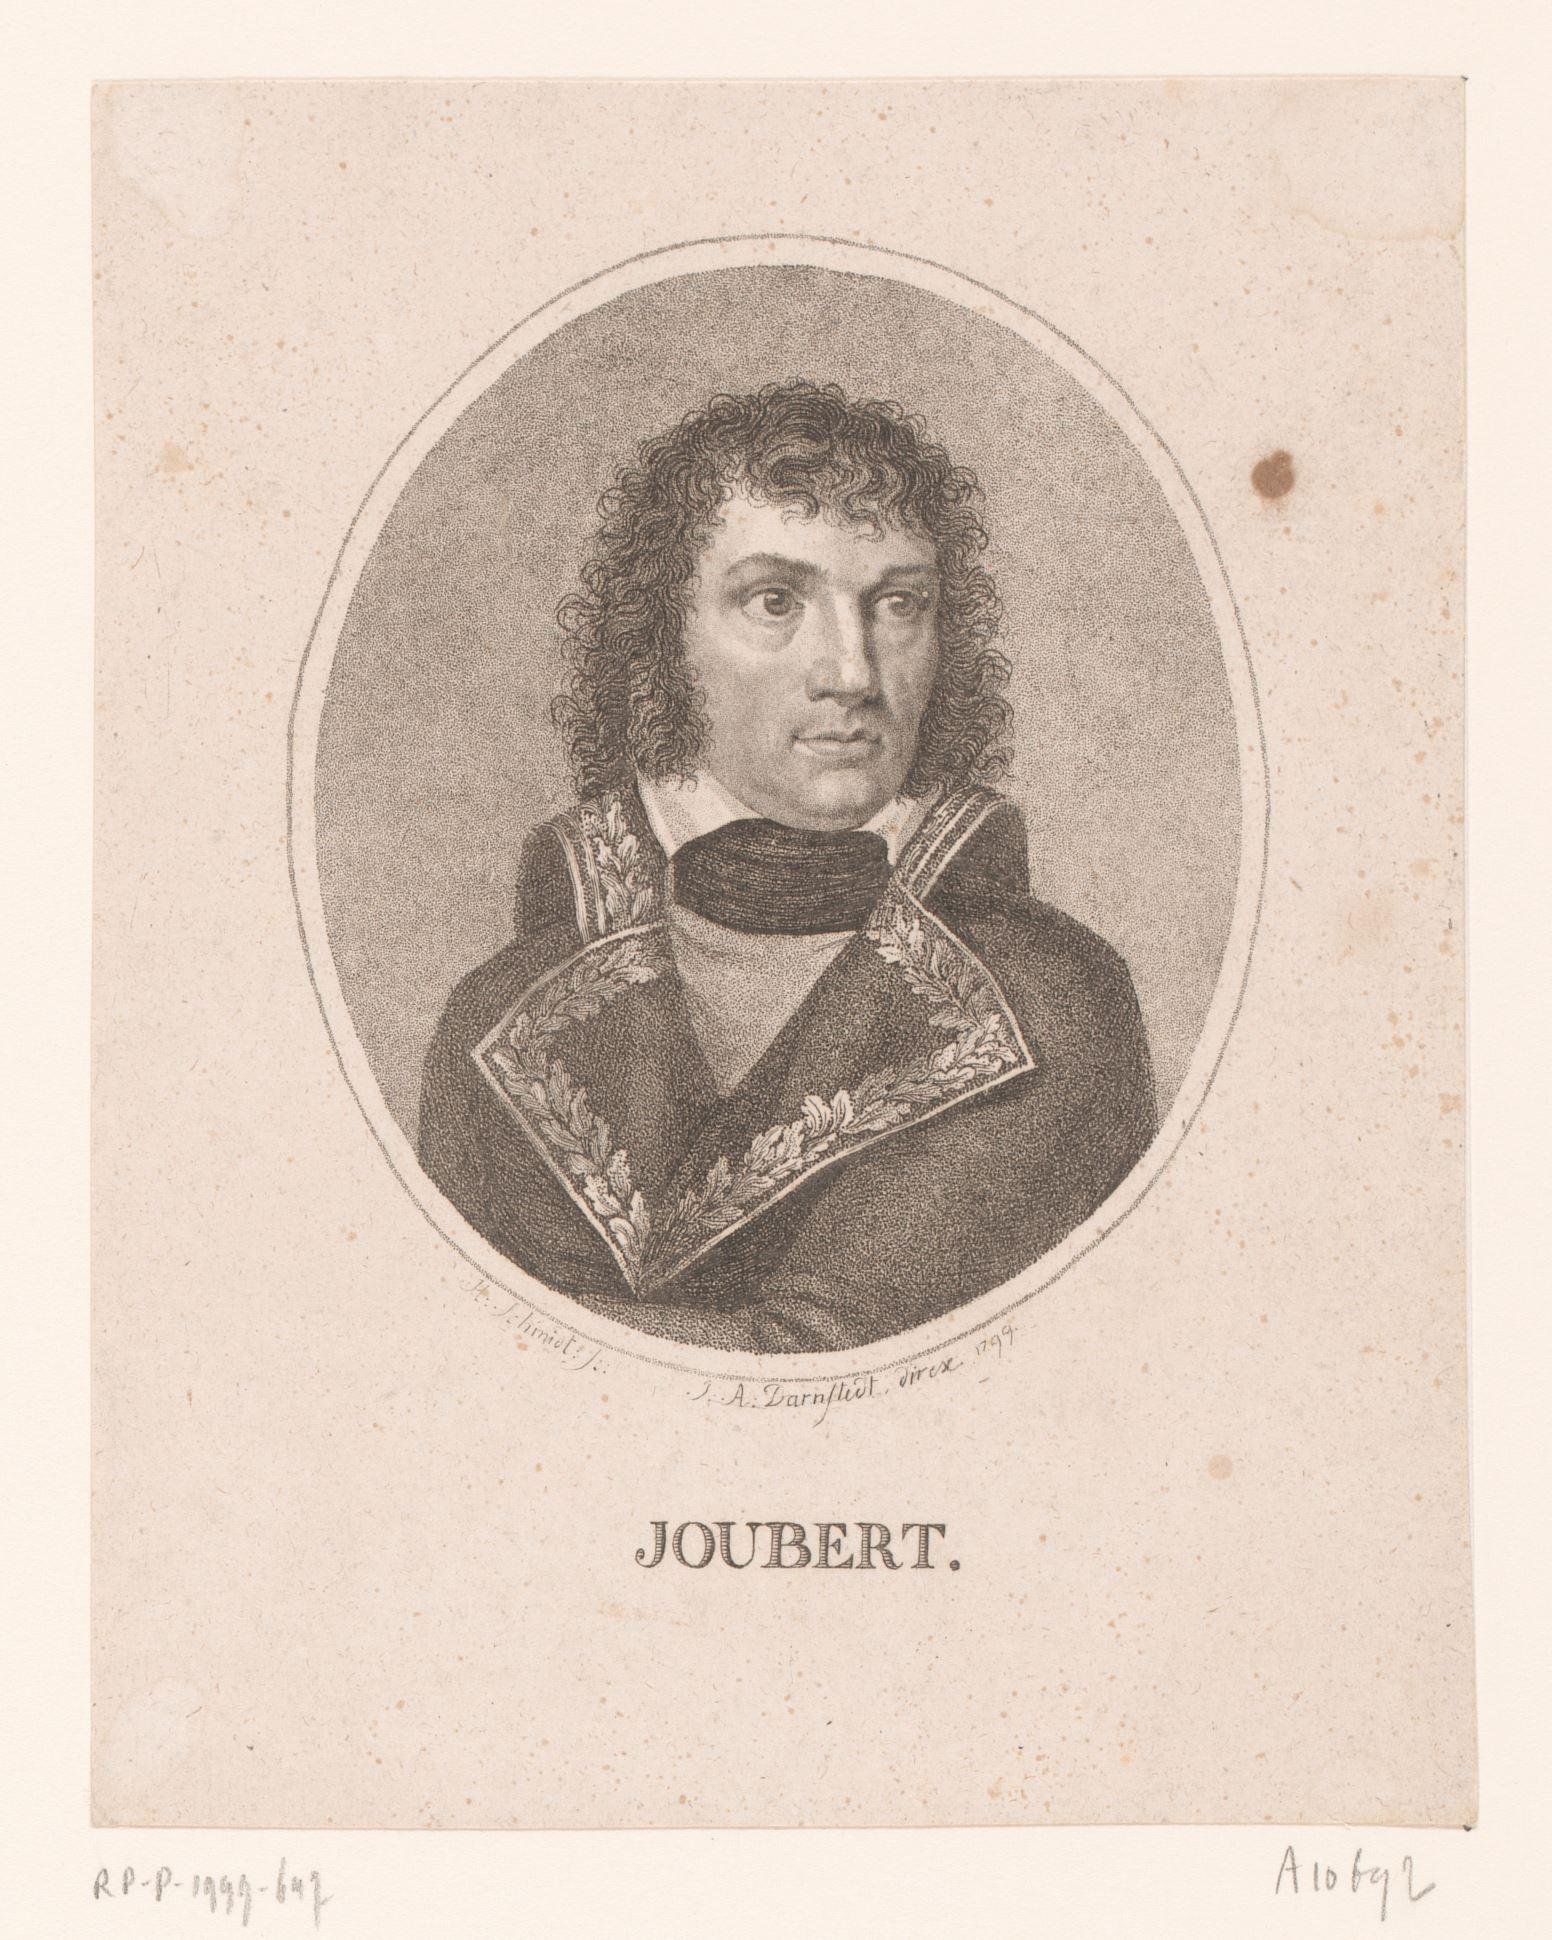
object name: print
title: Portret van Portret van Barthélémy Catherine Joubert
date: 1799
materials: paper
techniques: engraving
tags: historical persons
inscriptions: collector's mark: Lugt 2228, collector's mark: Lugt 2760